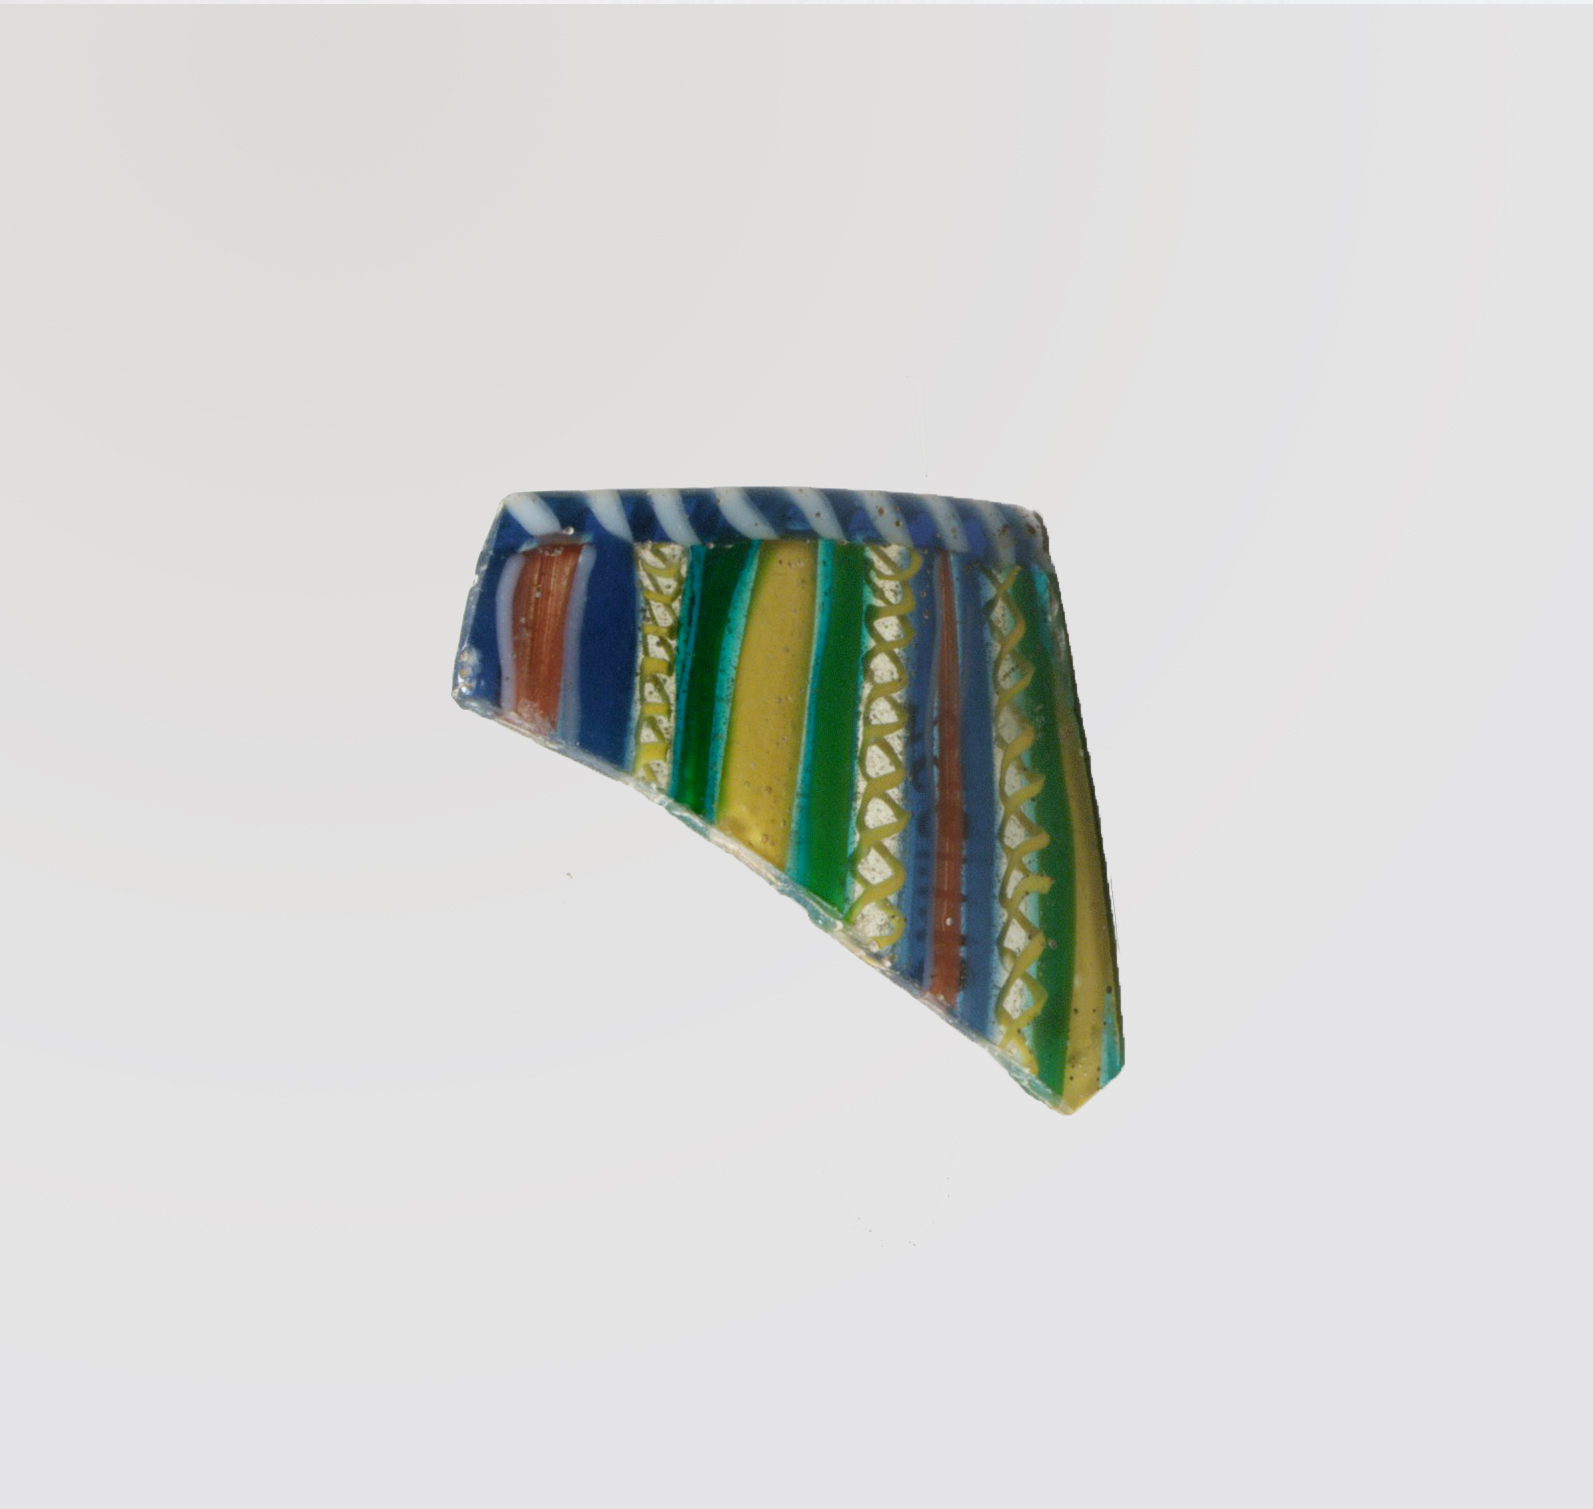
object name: fragment, striped mosaic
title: Glass striped mosaic bowl fragment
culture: roman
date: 34 BCE-33 CE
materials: glass